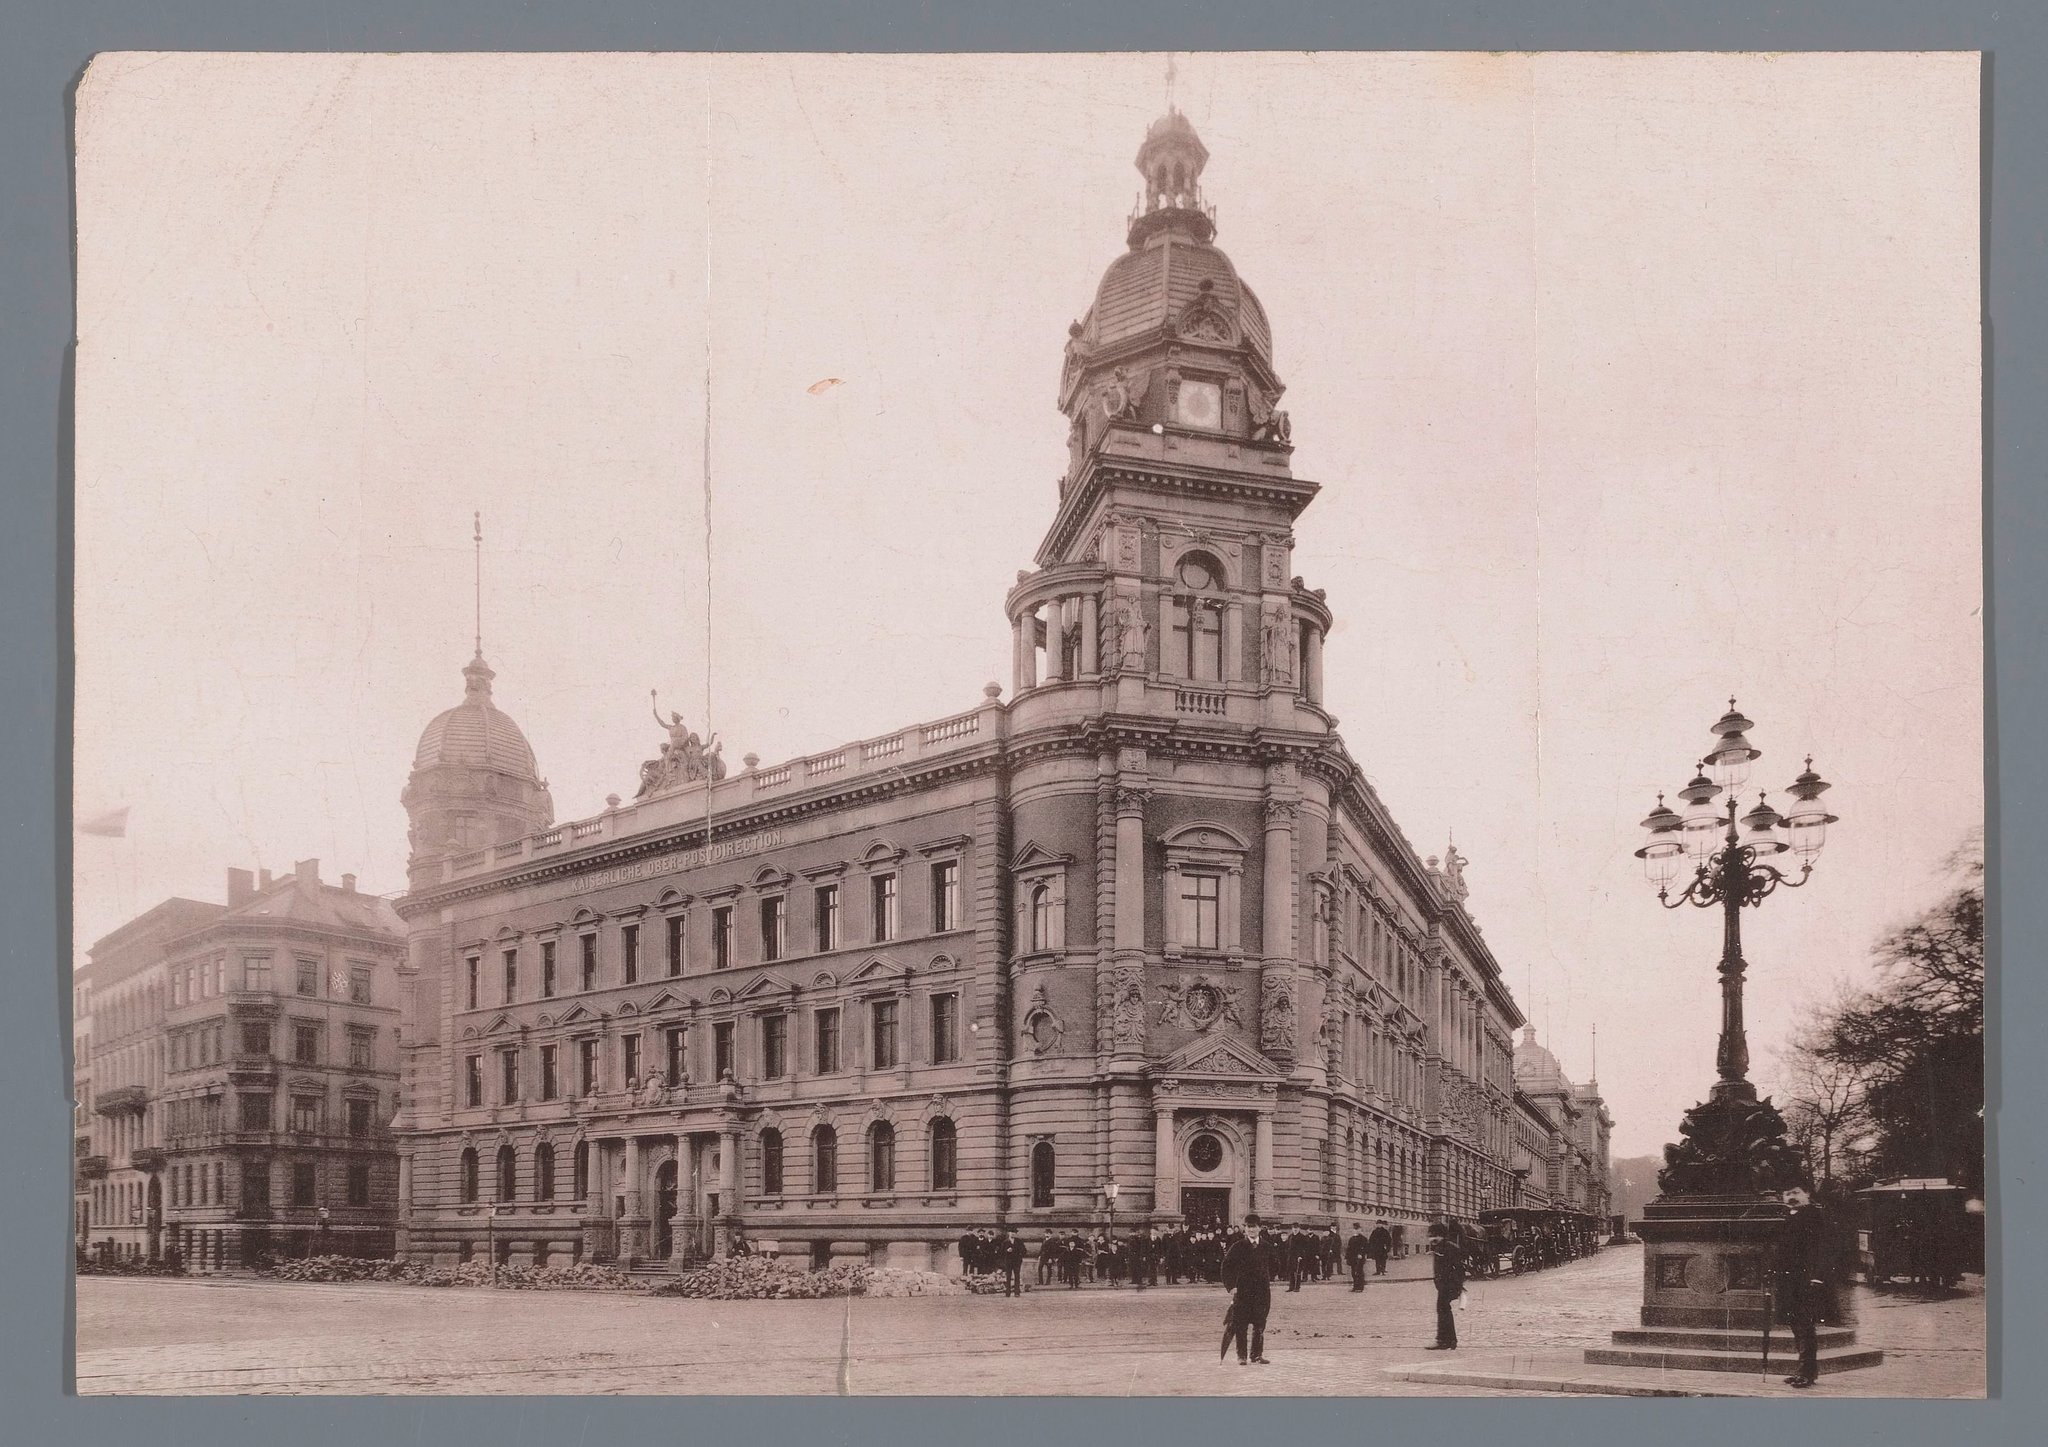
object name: photomechanical print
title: Plein met gebouw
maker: Anonymous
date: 1887-1910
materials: paper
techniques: photograph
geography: hamburg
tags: post-office